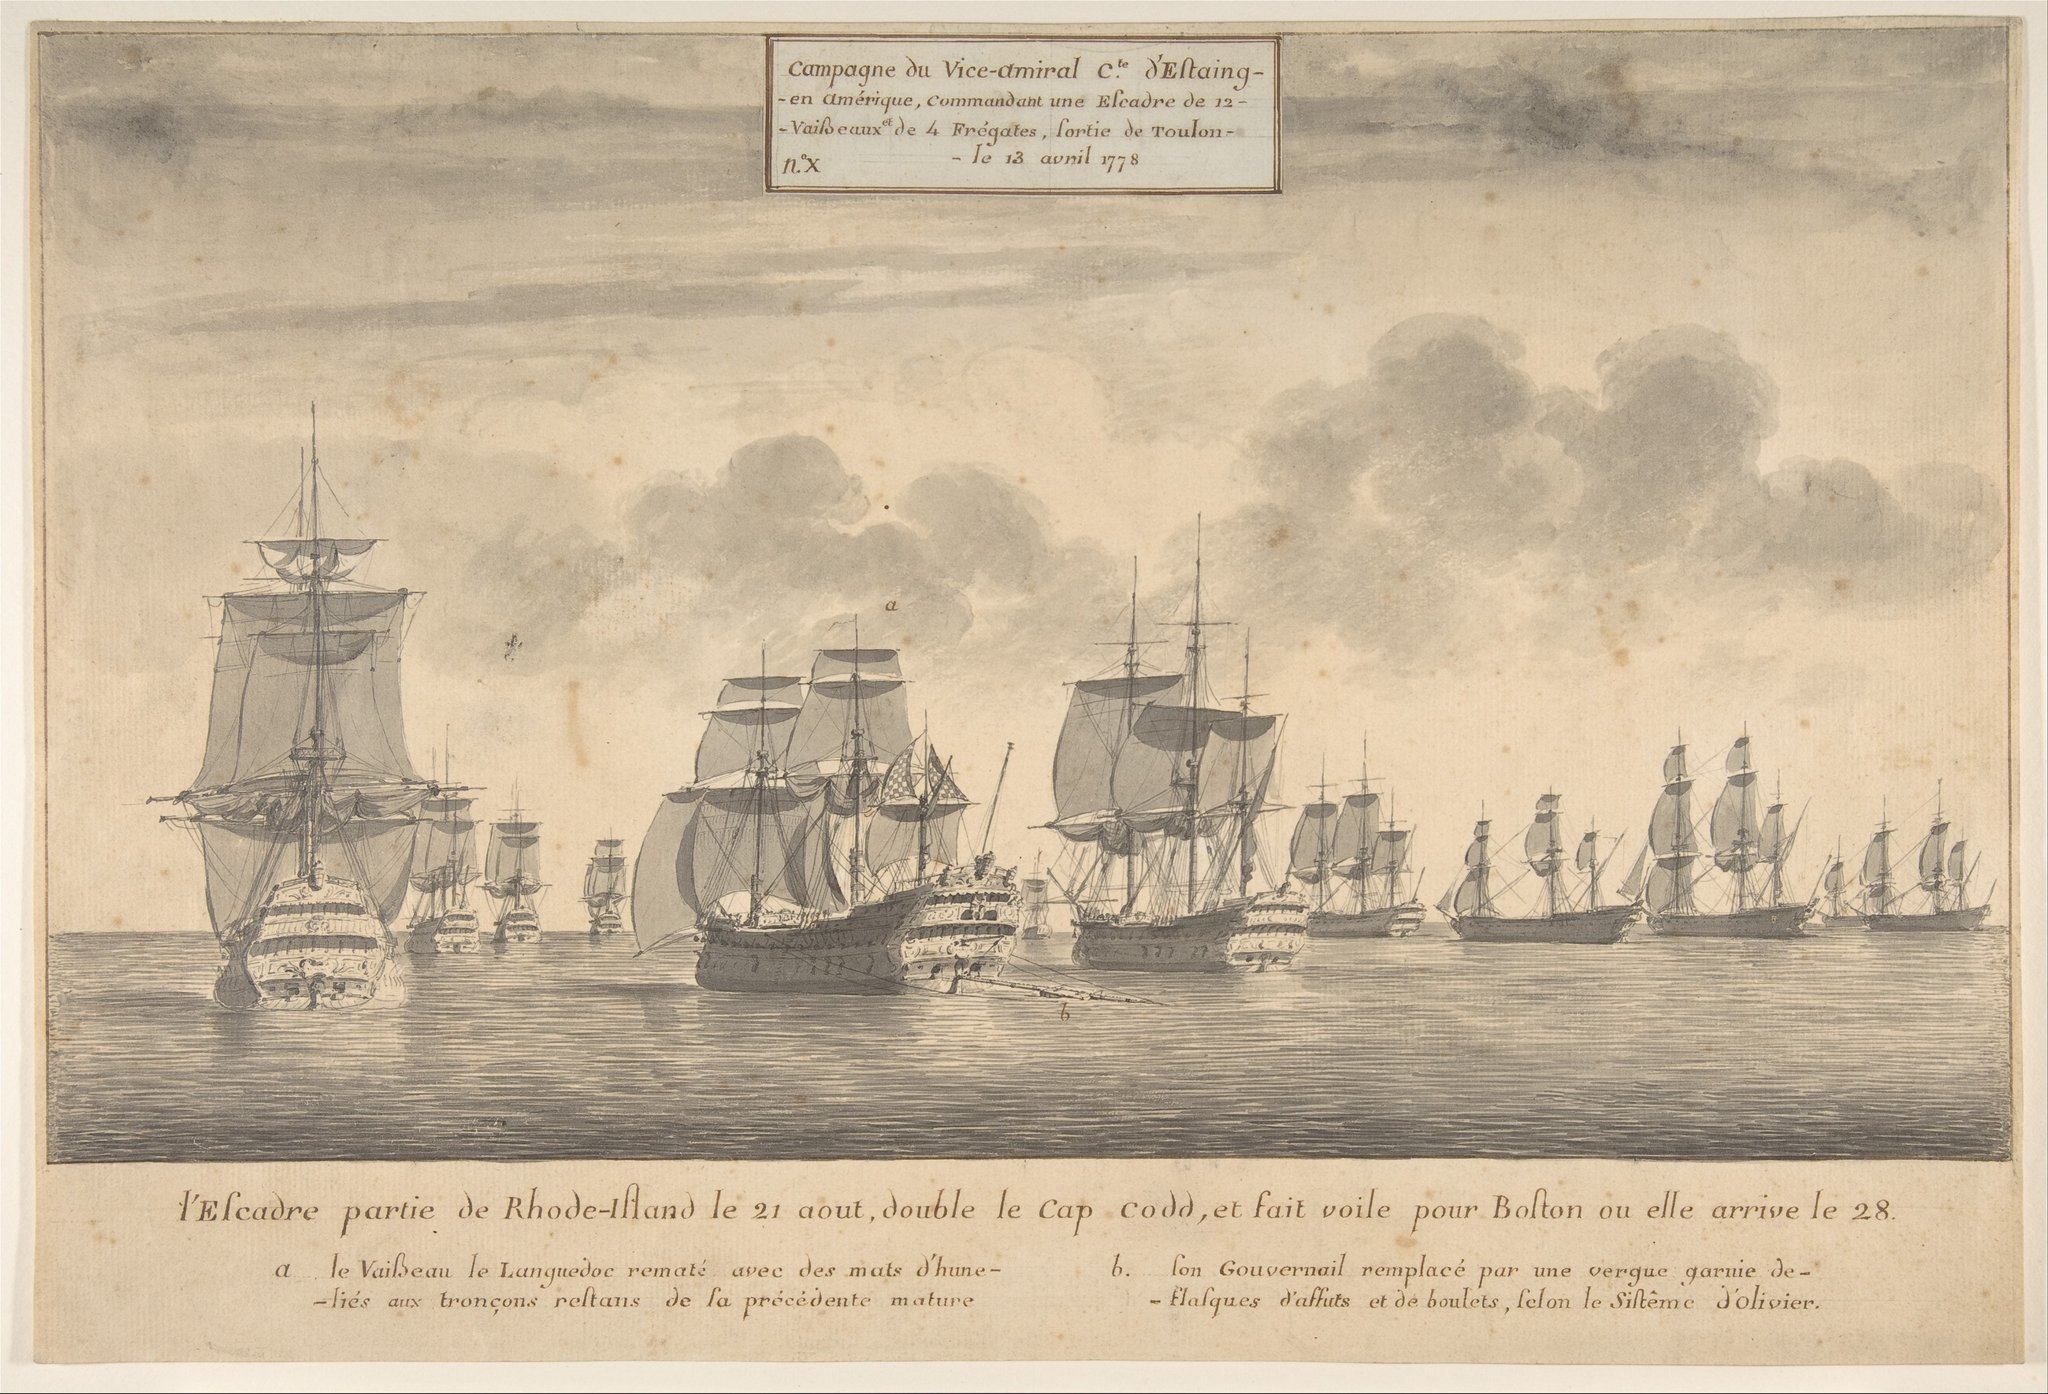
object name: drawing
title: Campagne du Vice-amiral Cte d'Estaing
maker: pierre ozanne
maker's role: artist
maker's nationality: french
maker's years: 1737-1813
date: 1778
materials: ink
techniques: brush, pen, wash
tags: ships